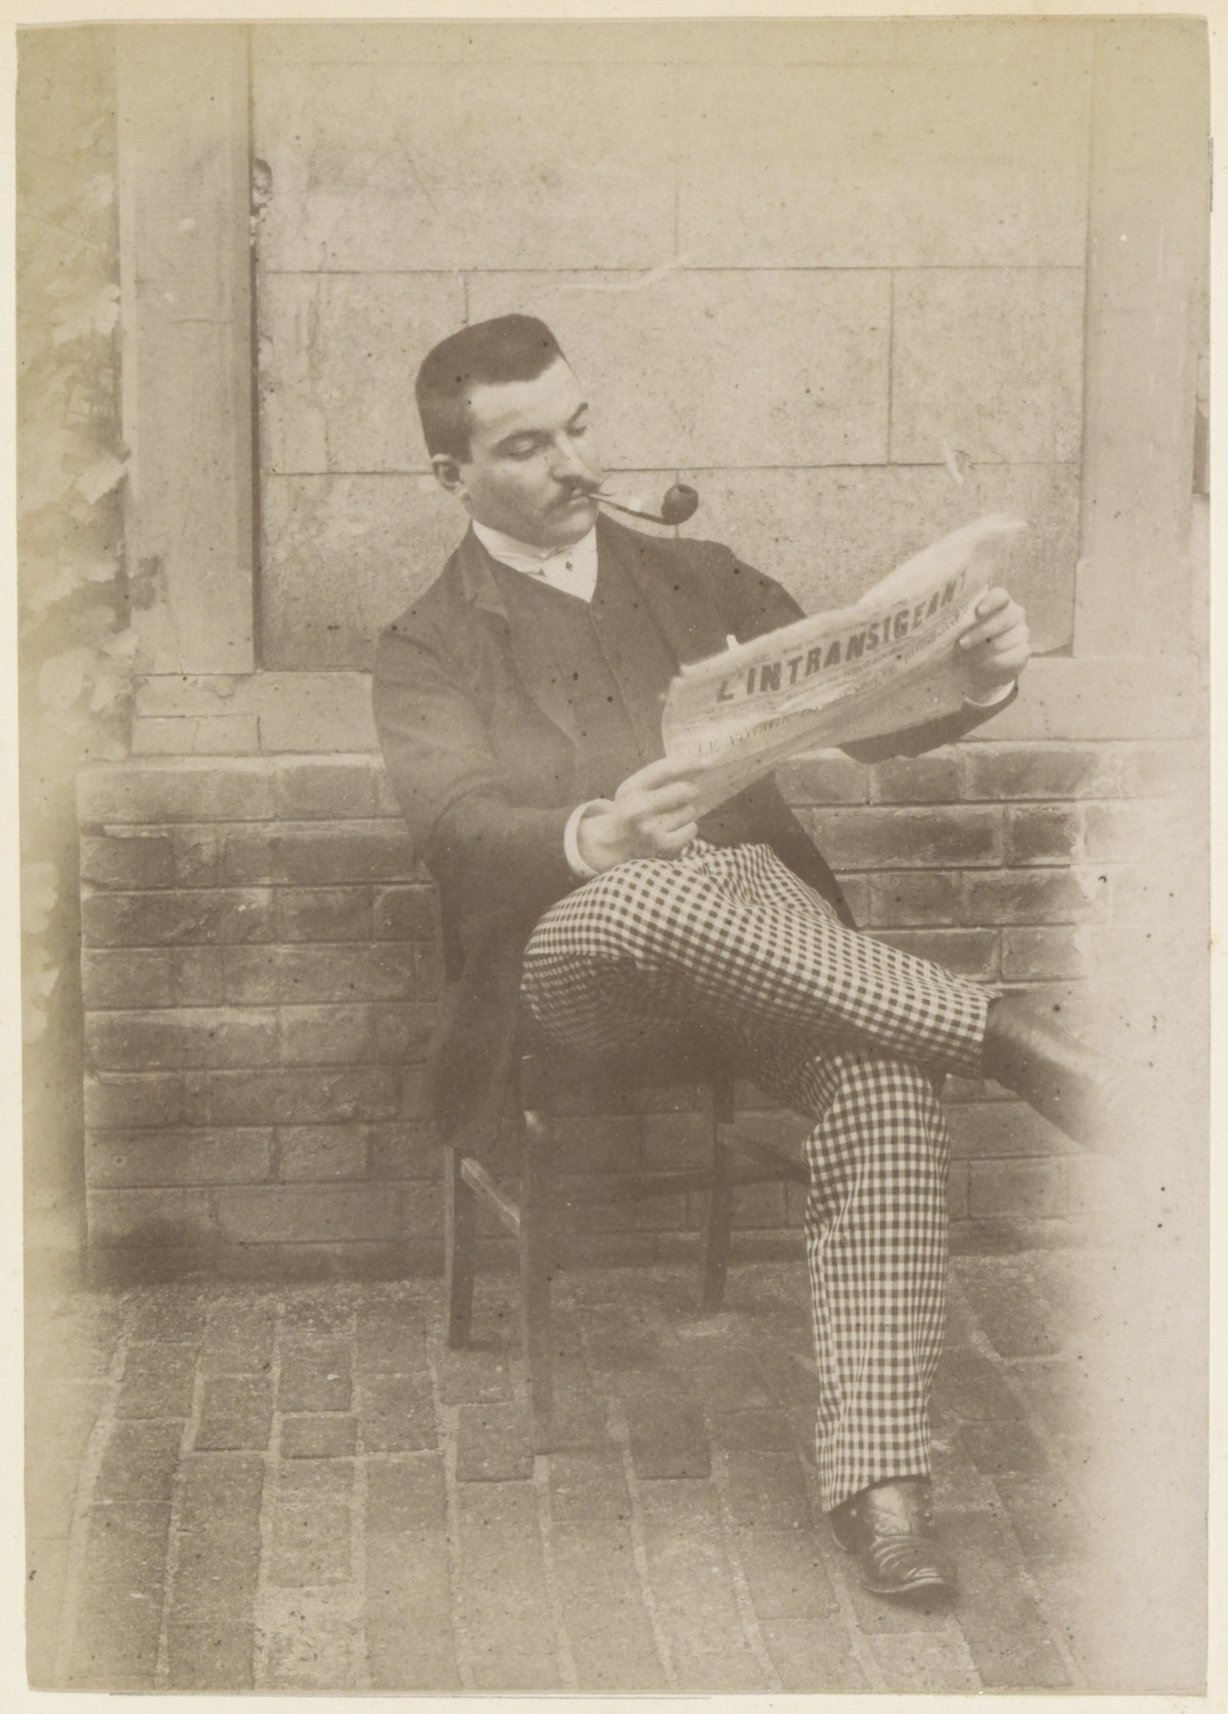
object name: photograph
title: Portret van een zittende Franse man met een pijp en een geruite broek, de krant 'L'Intransigeant' lezend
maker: Anonymous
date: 1900-1910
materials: paper, photographic support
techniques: albumen print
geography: france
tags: trousers, breeches, adult man, pipe ~ tobacco, newspaper, news-sheet, france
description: Onderdeel van Fotoalbum van een Franse amateurfotograaf met opnames van een familie, distilleerderij Delizy & Doistau Fils, het leger en bezienswaardigheden in Frankrijk.